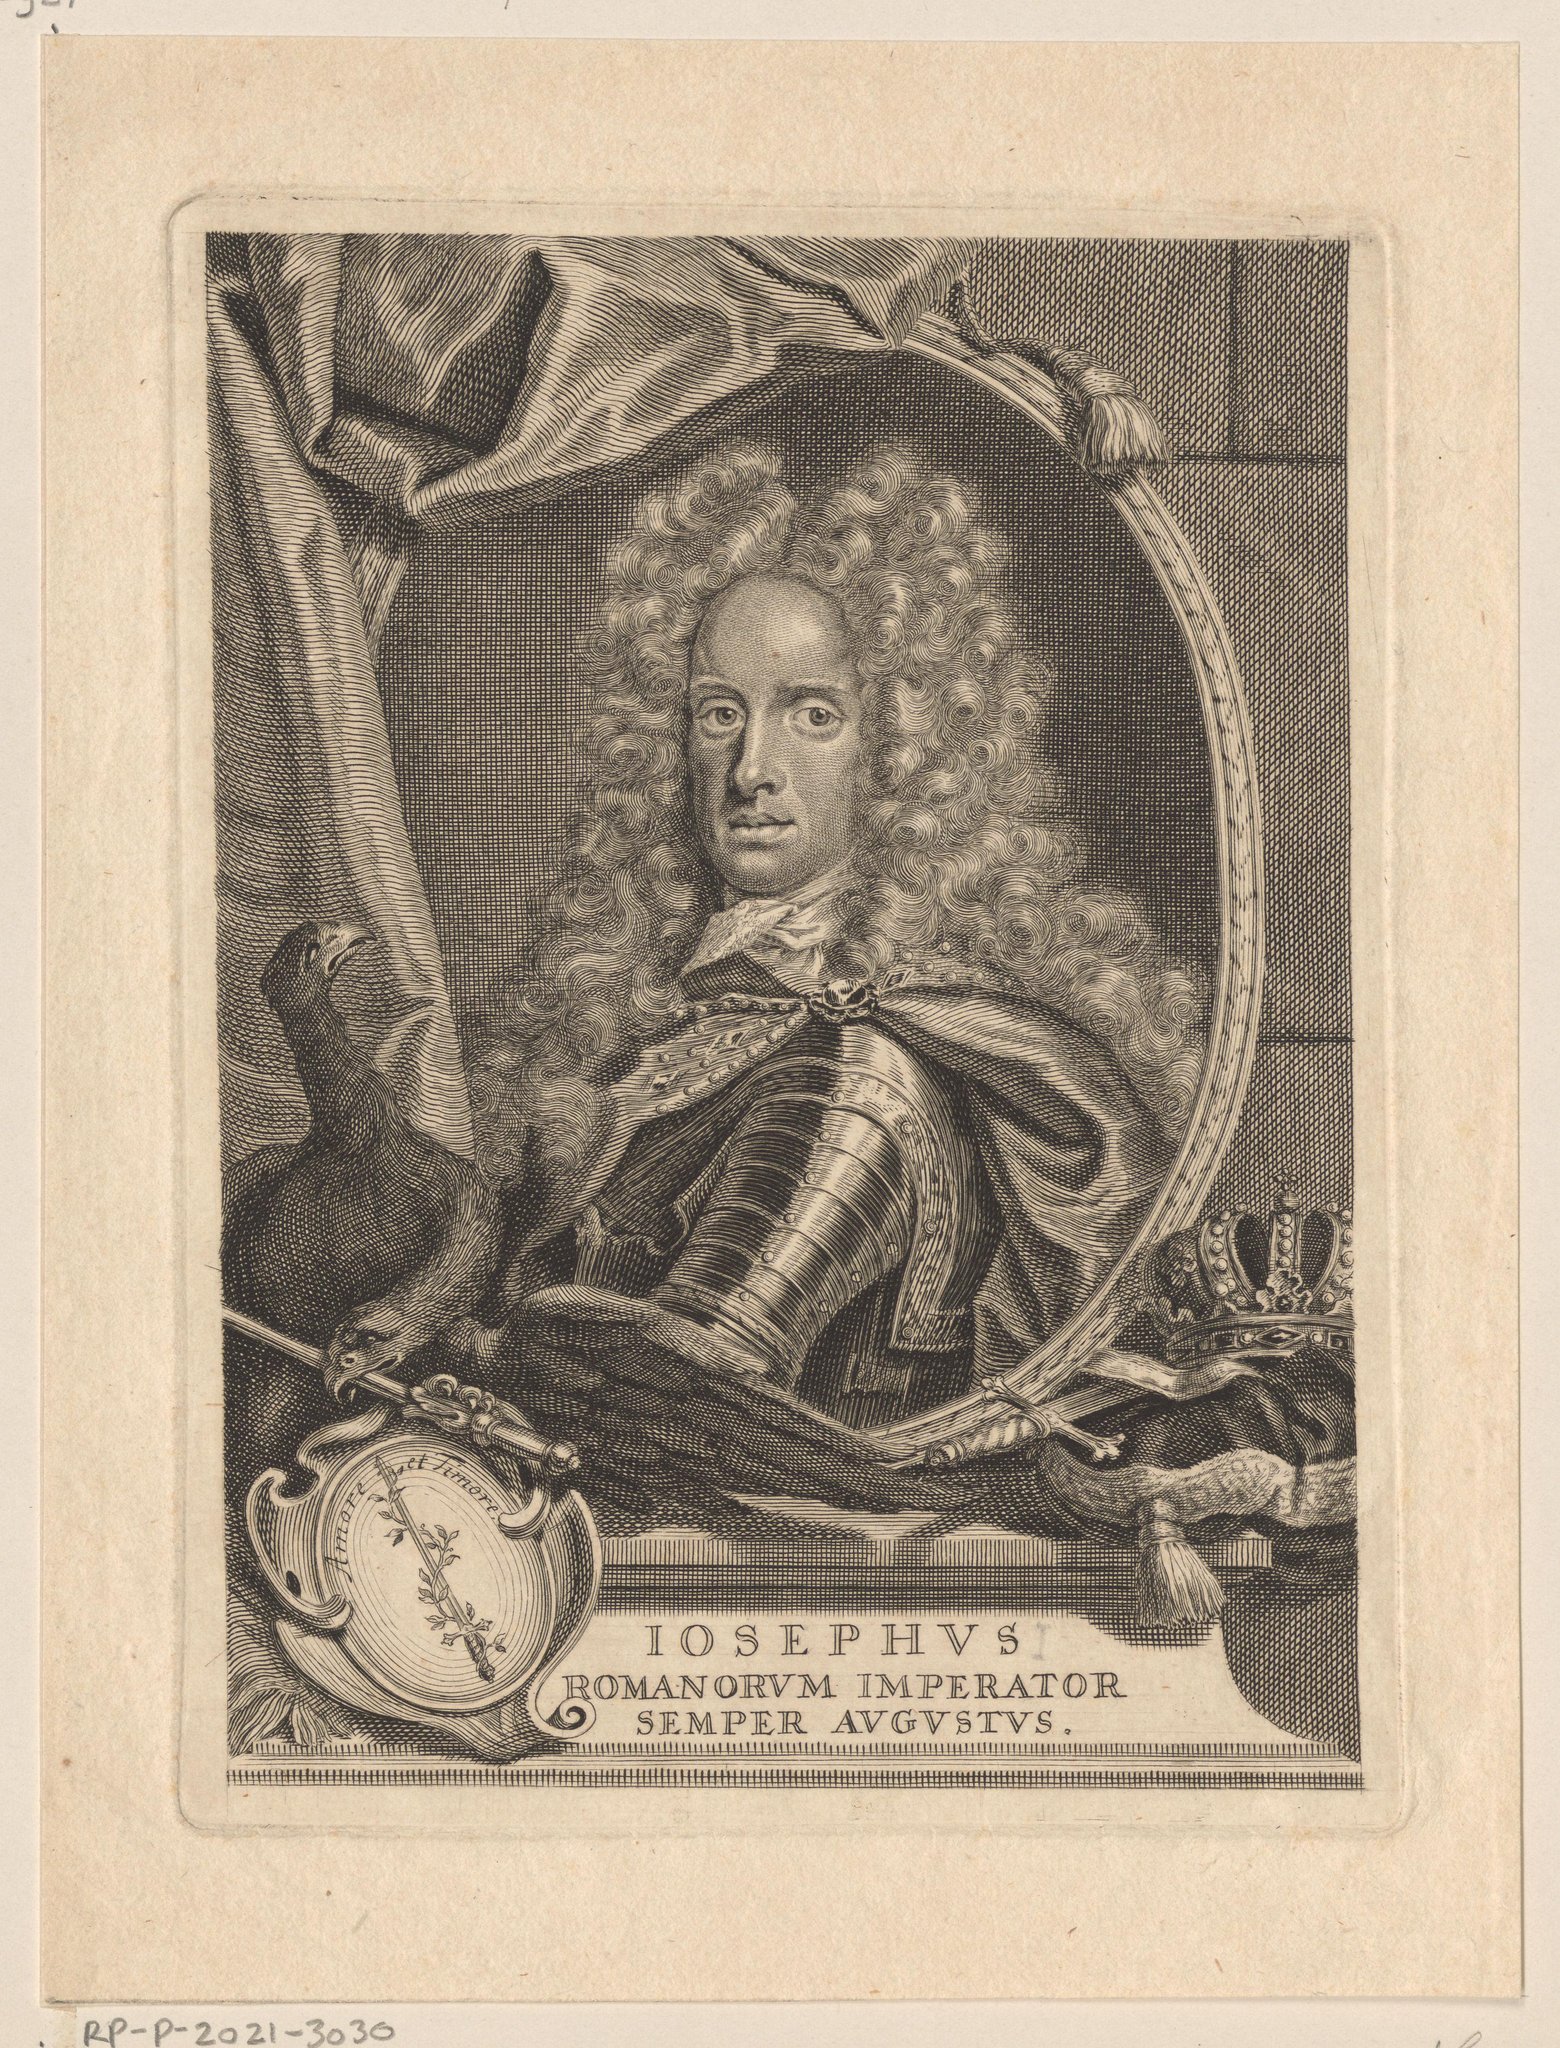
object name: print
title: Portret van Jozef I, Duits keizer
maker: Anonymous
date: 1705-1799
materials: paper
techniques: engraving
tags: vienna, jozef i (duits keizer), historical persons, emperor, armorial bearing, heraldry, insignia and symbols of sovereignty (crown, diadem, sceptre, orb, seal, standard, cloak, pectoral)